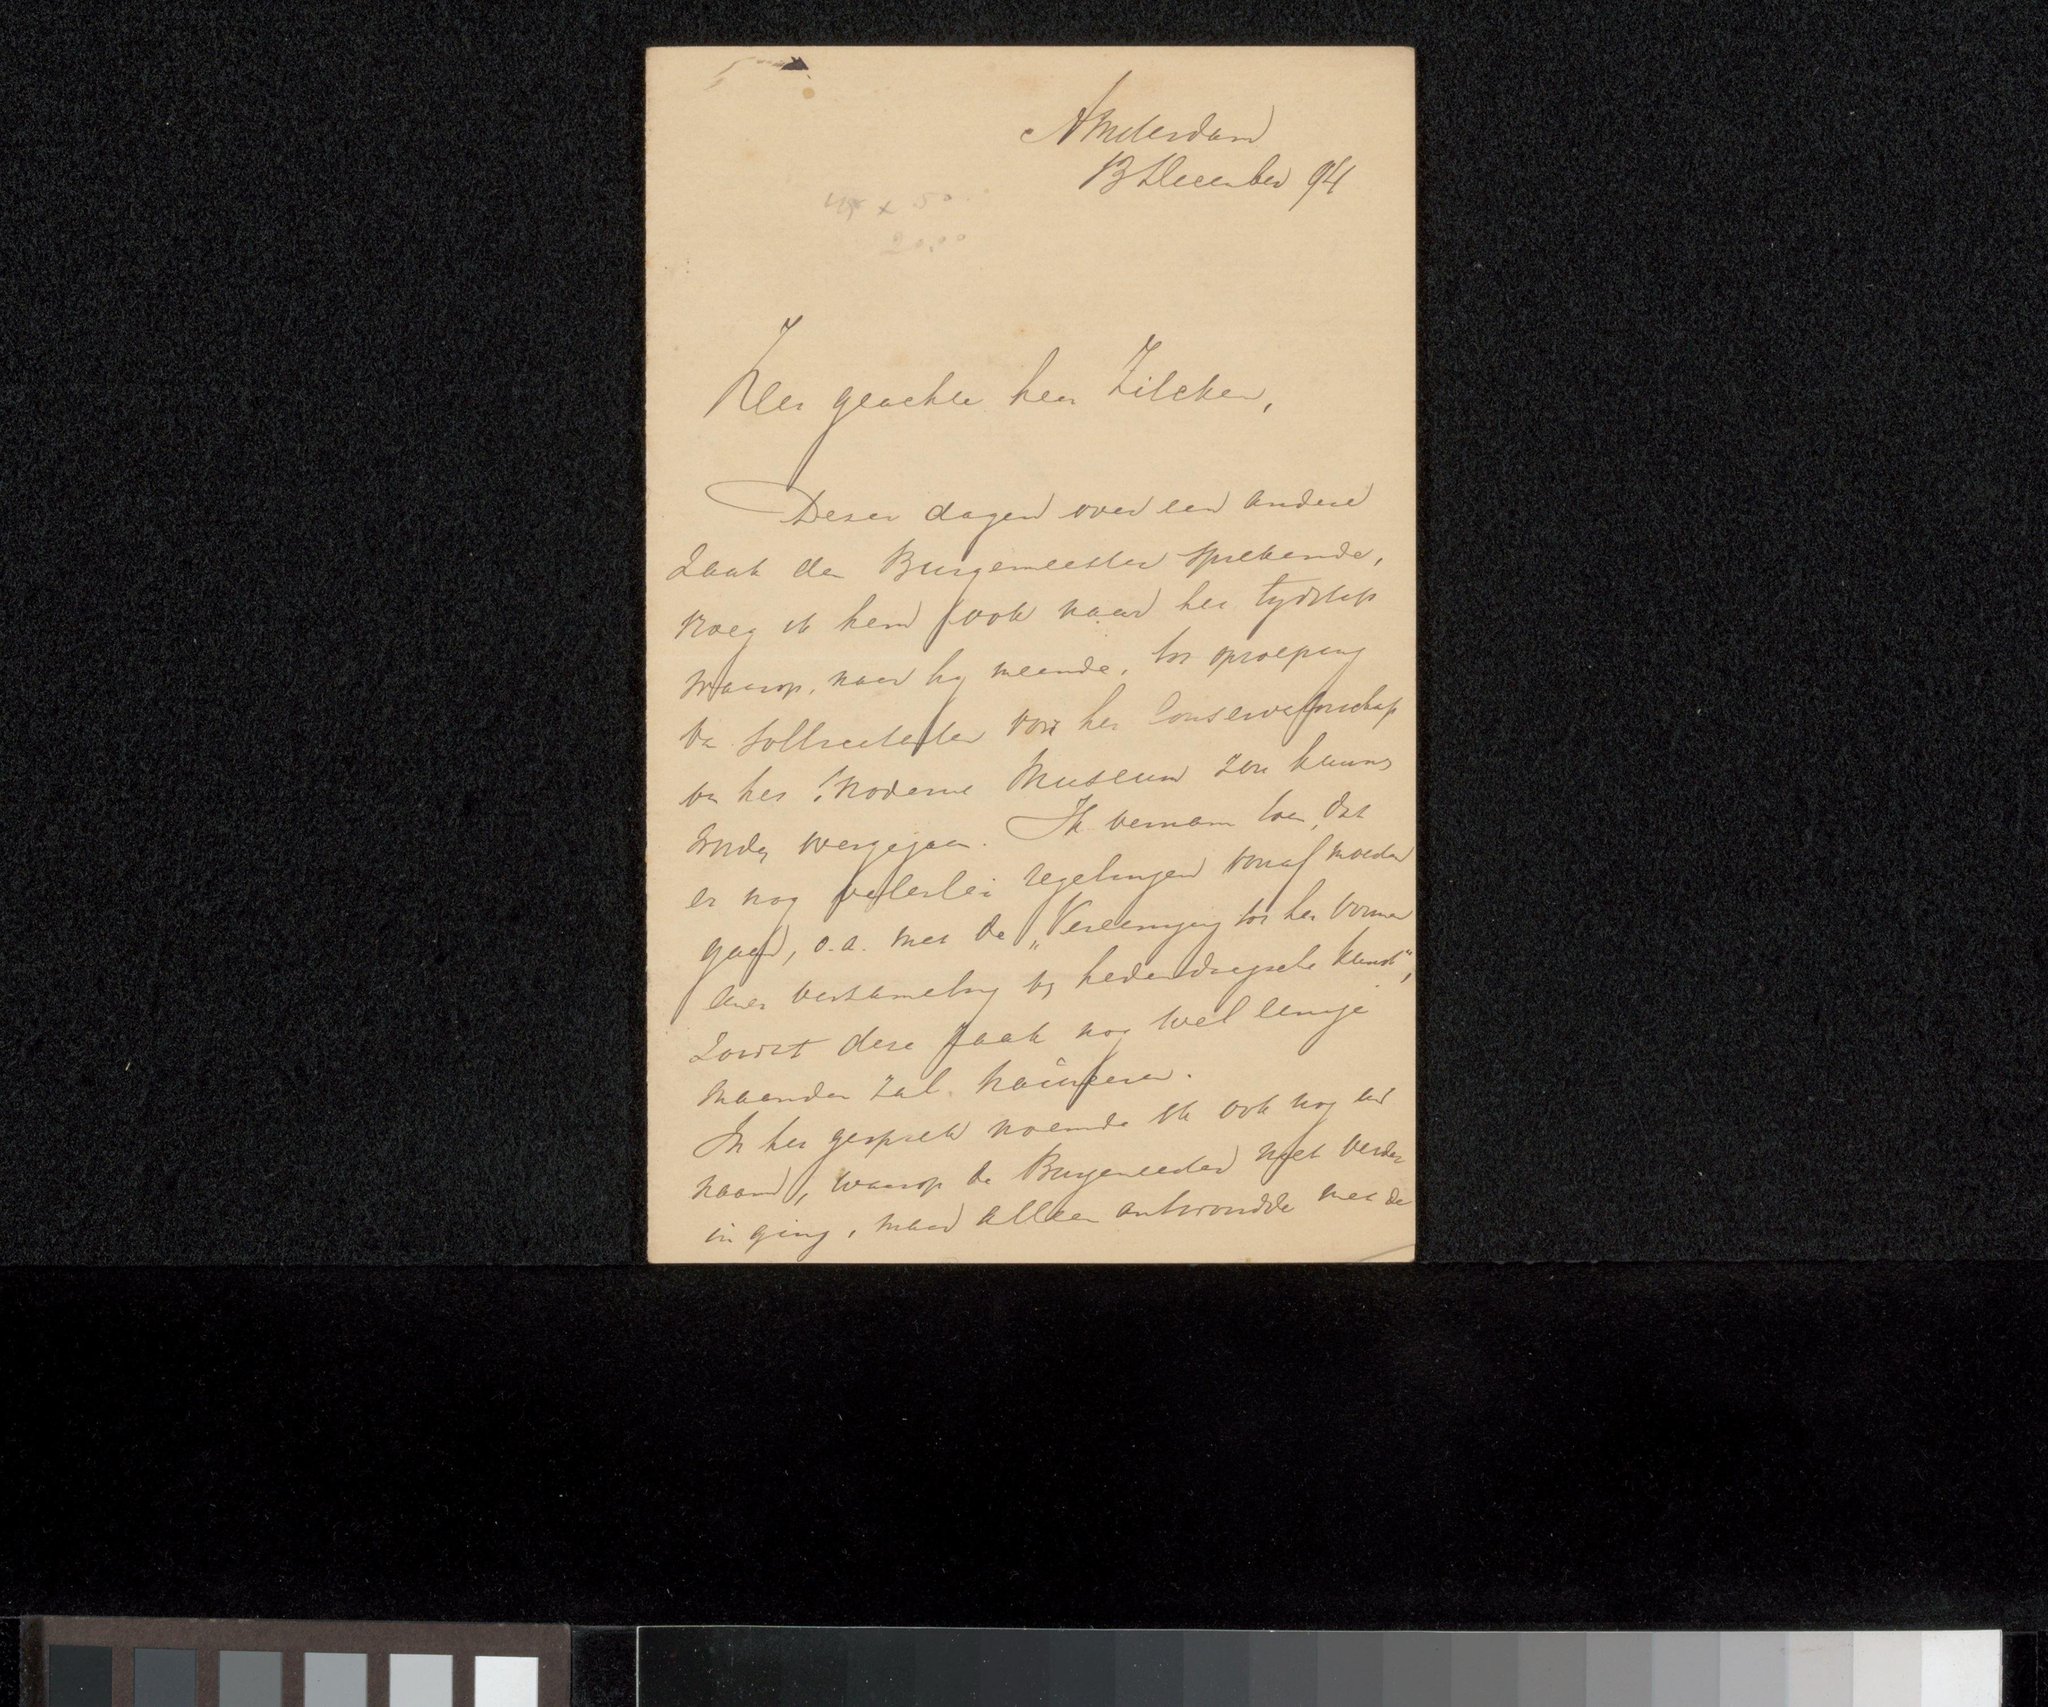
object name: letter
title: Brief aan Philip Zilcken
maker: jacob nicolaas van hall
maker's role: politician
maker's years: 1840-1918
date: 1894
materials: ink, paper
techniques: pen, writing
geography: amsterdam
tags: the hague, painter, draughtsman, philip zilcken, permanent exhibition, museum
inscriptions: collector's mark: ‘RPK’